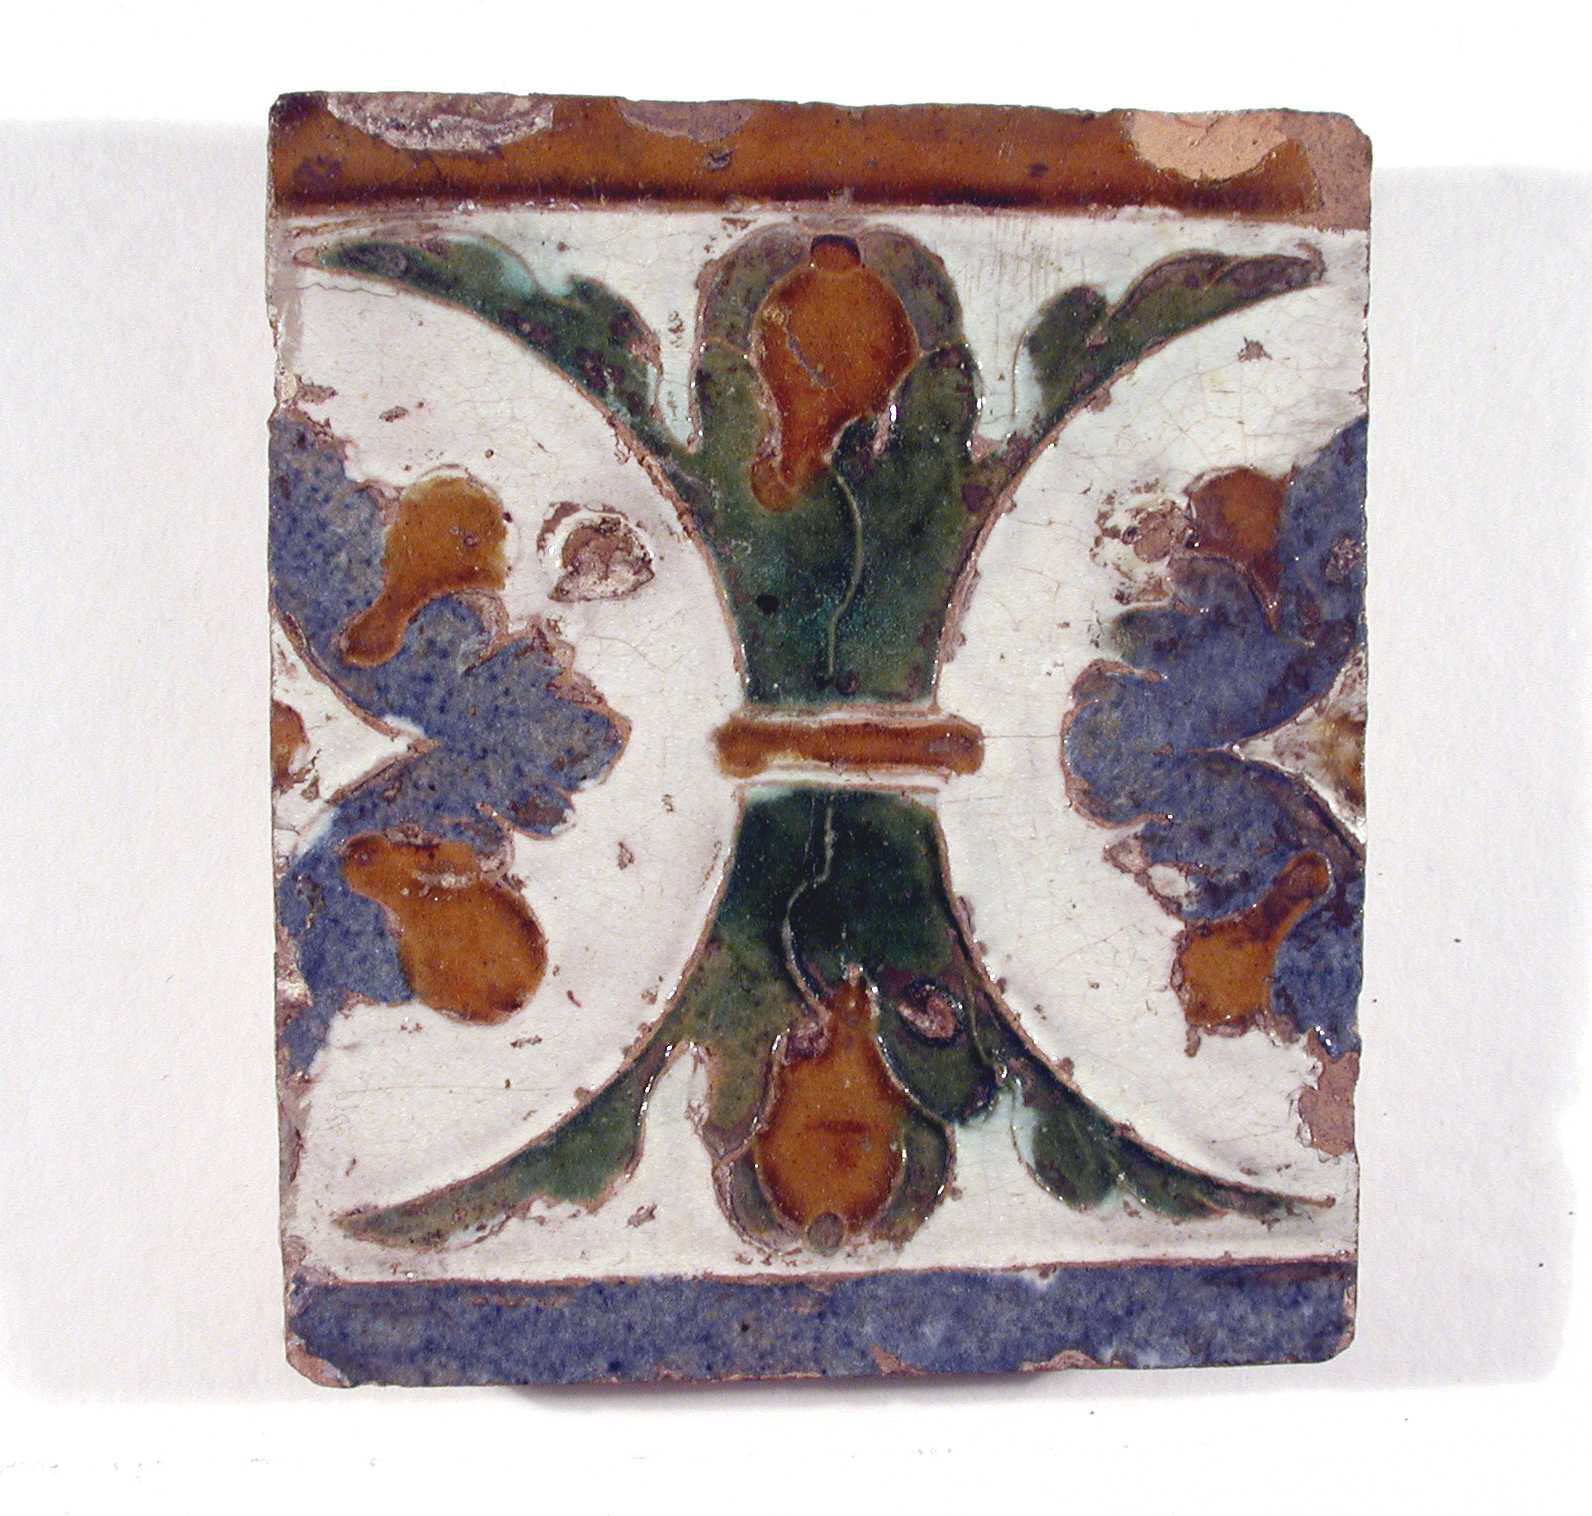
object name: wall tile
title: 24 wall tiles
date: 1501-1700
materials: earthenware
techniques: glazing